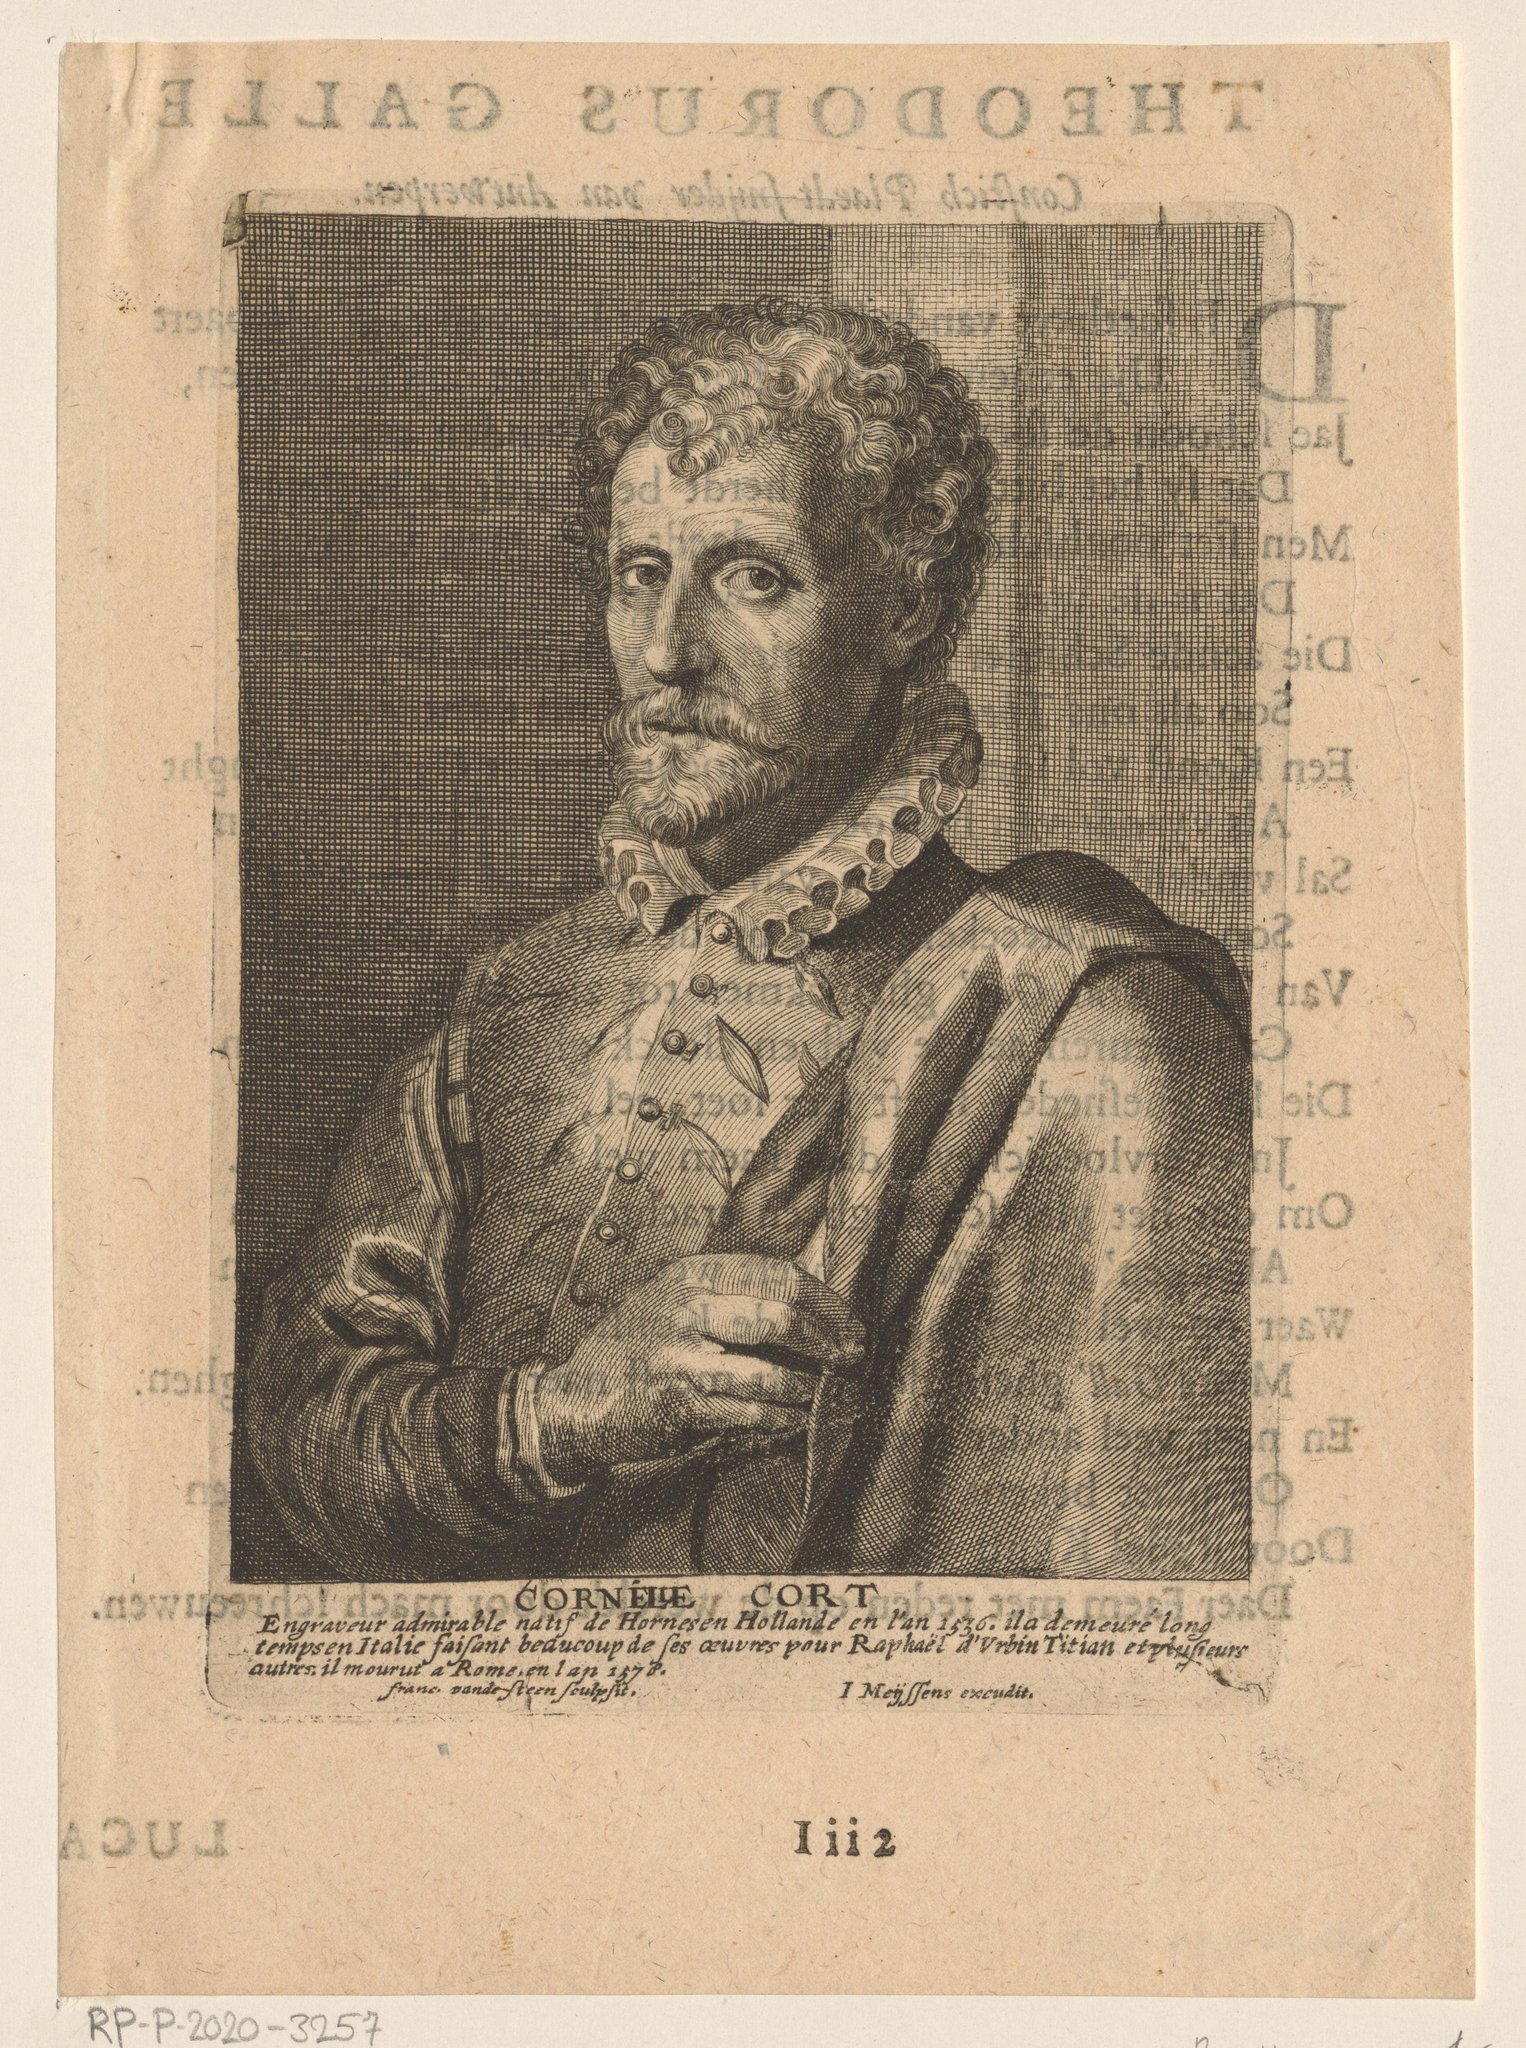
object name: book illustration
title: Portret van Cornelis Cort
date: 1662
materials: paper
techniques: engraving, etching, letterpress printing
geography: antwerp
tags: rome, print maker, cornelis cort, historical persons, portrait, self-portrait of painter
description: Prent uit: Bie, Cornelis de. Het gulden Cabinet vande edel vry schilder const (...). Antwerpen: Joannes Meyssens, 1662 [1661 foutief op titelpagina], p. 451.